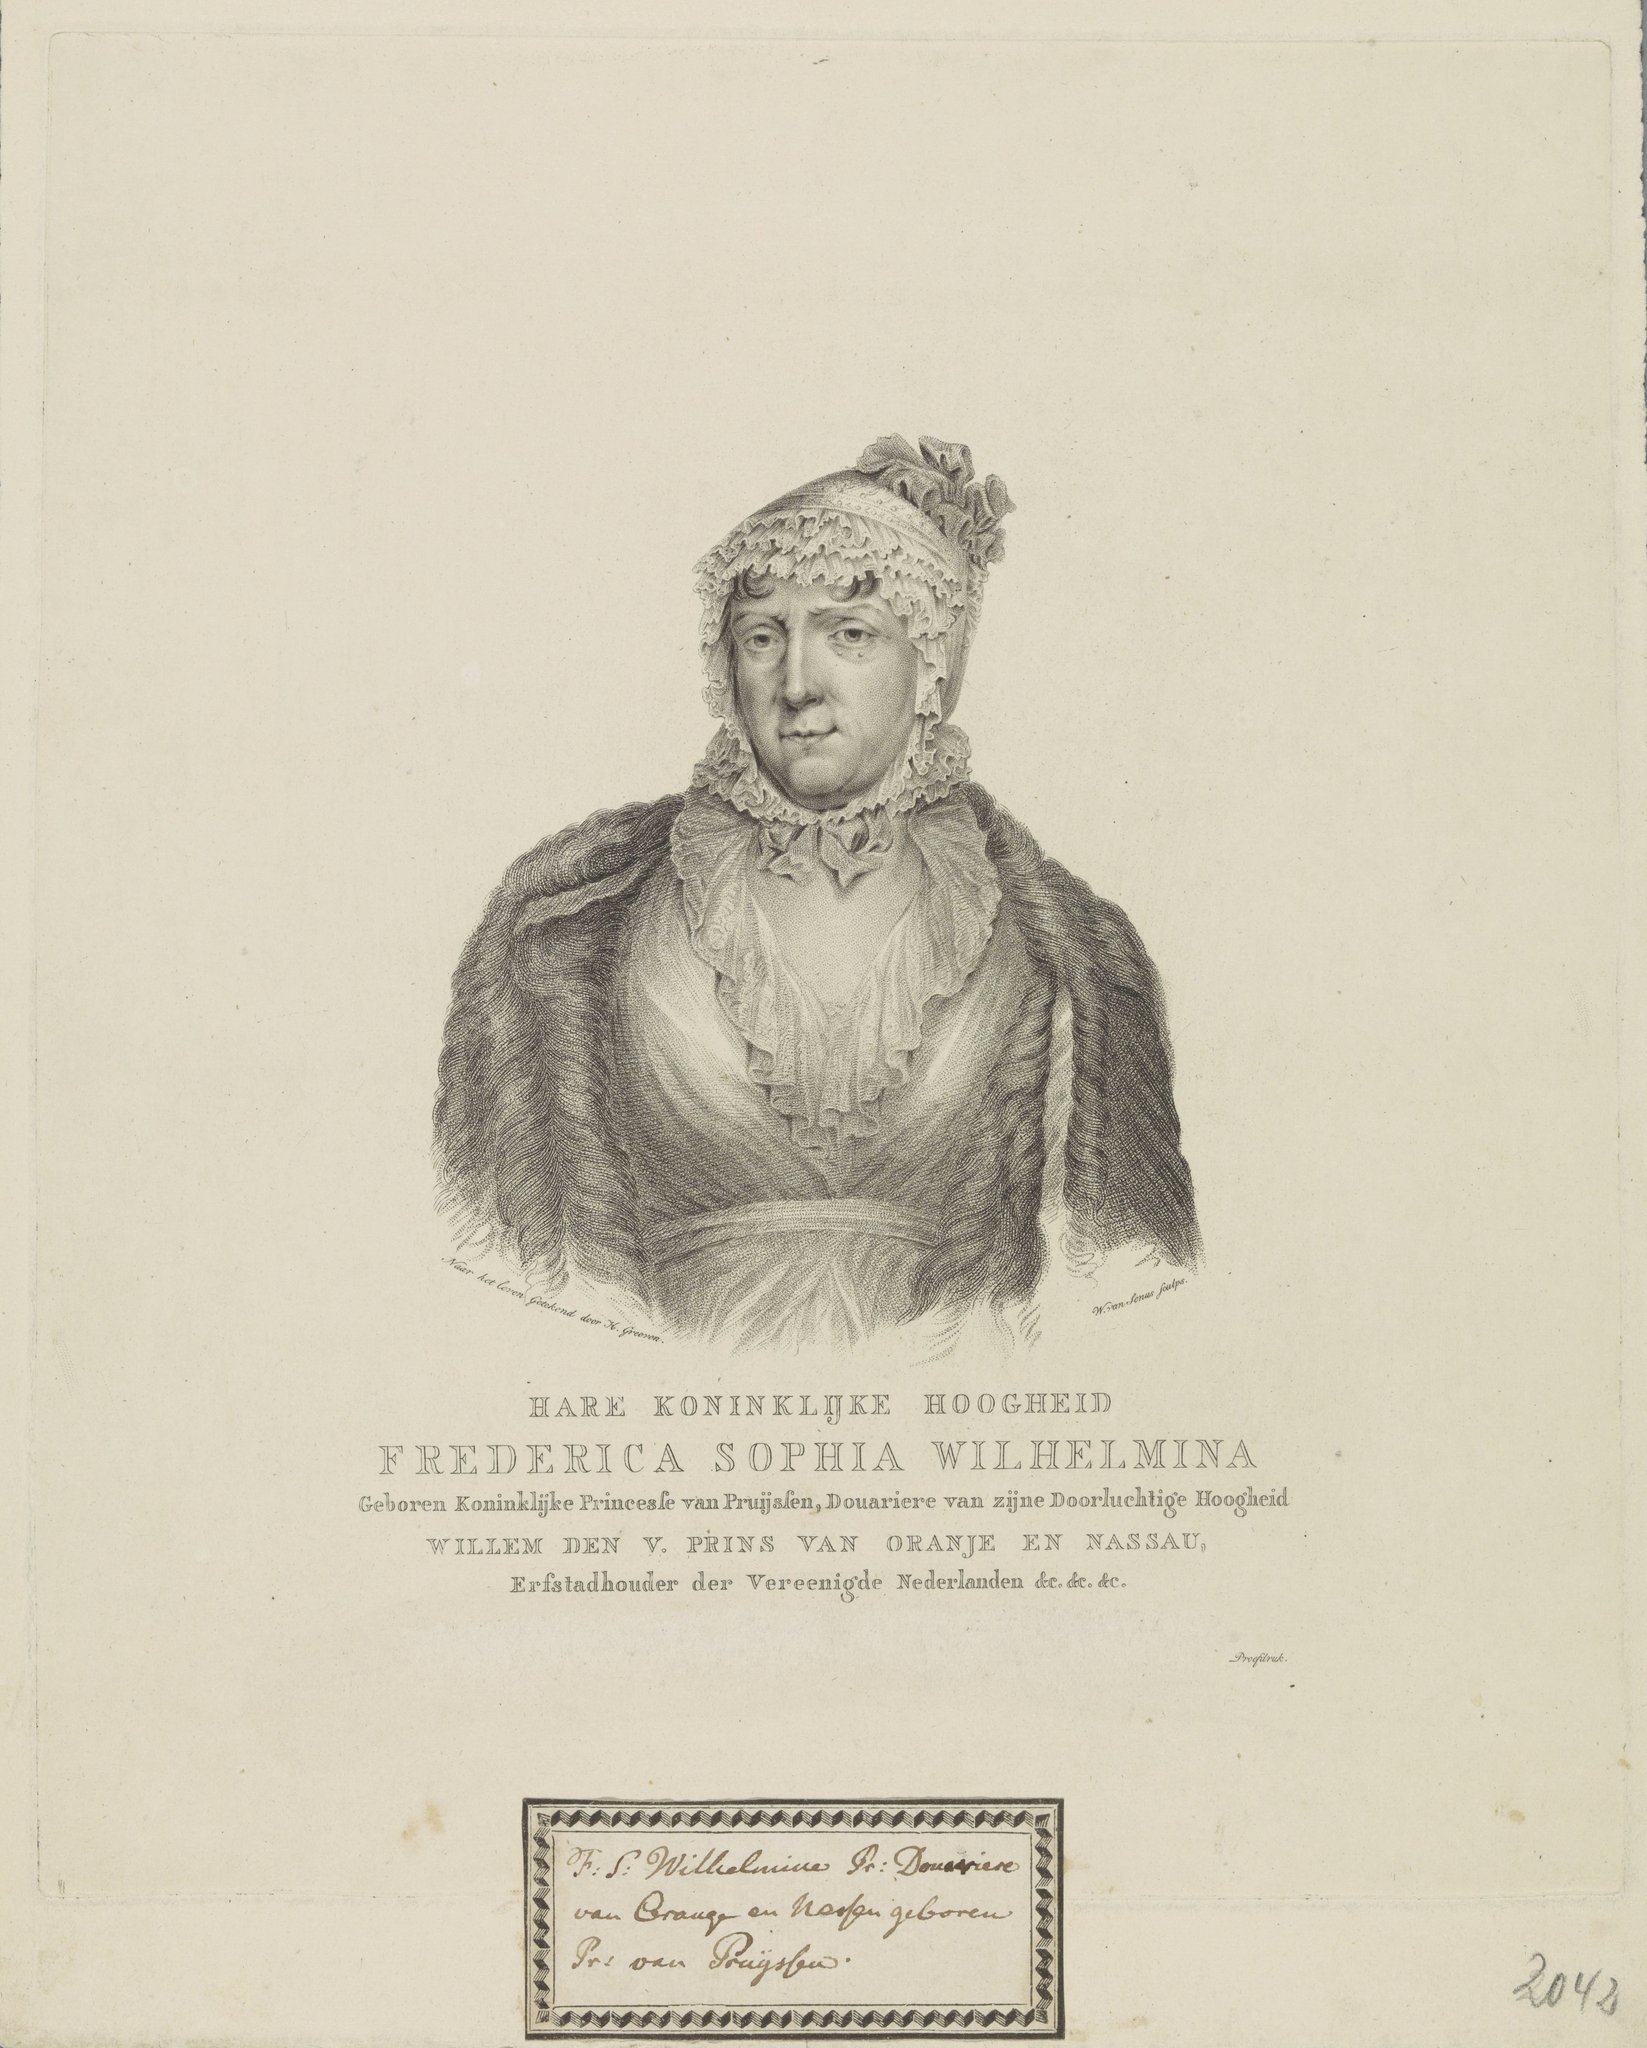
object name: manuscript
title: Portret van Wilhelmina van Pruisen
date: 1815-1851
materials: paper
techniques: engraving, etching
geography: amsterdam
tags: berlin, draughtsman, wilhelmina of prussia (princess of orange)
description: Portret van Wilhelmina. In de ondermarge vijf regels Nederlandse tekst. Rechtsonder 'Proefdruk'. Daaronder losse opgeplakte handtekening met pen.